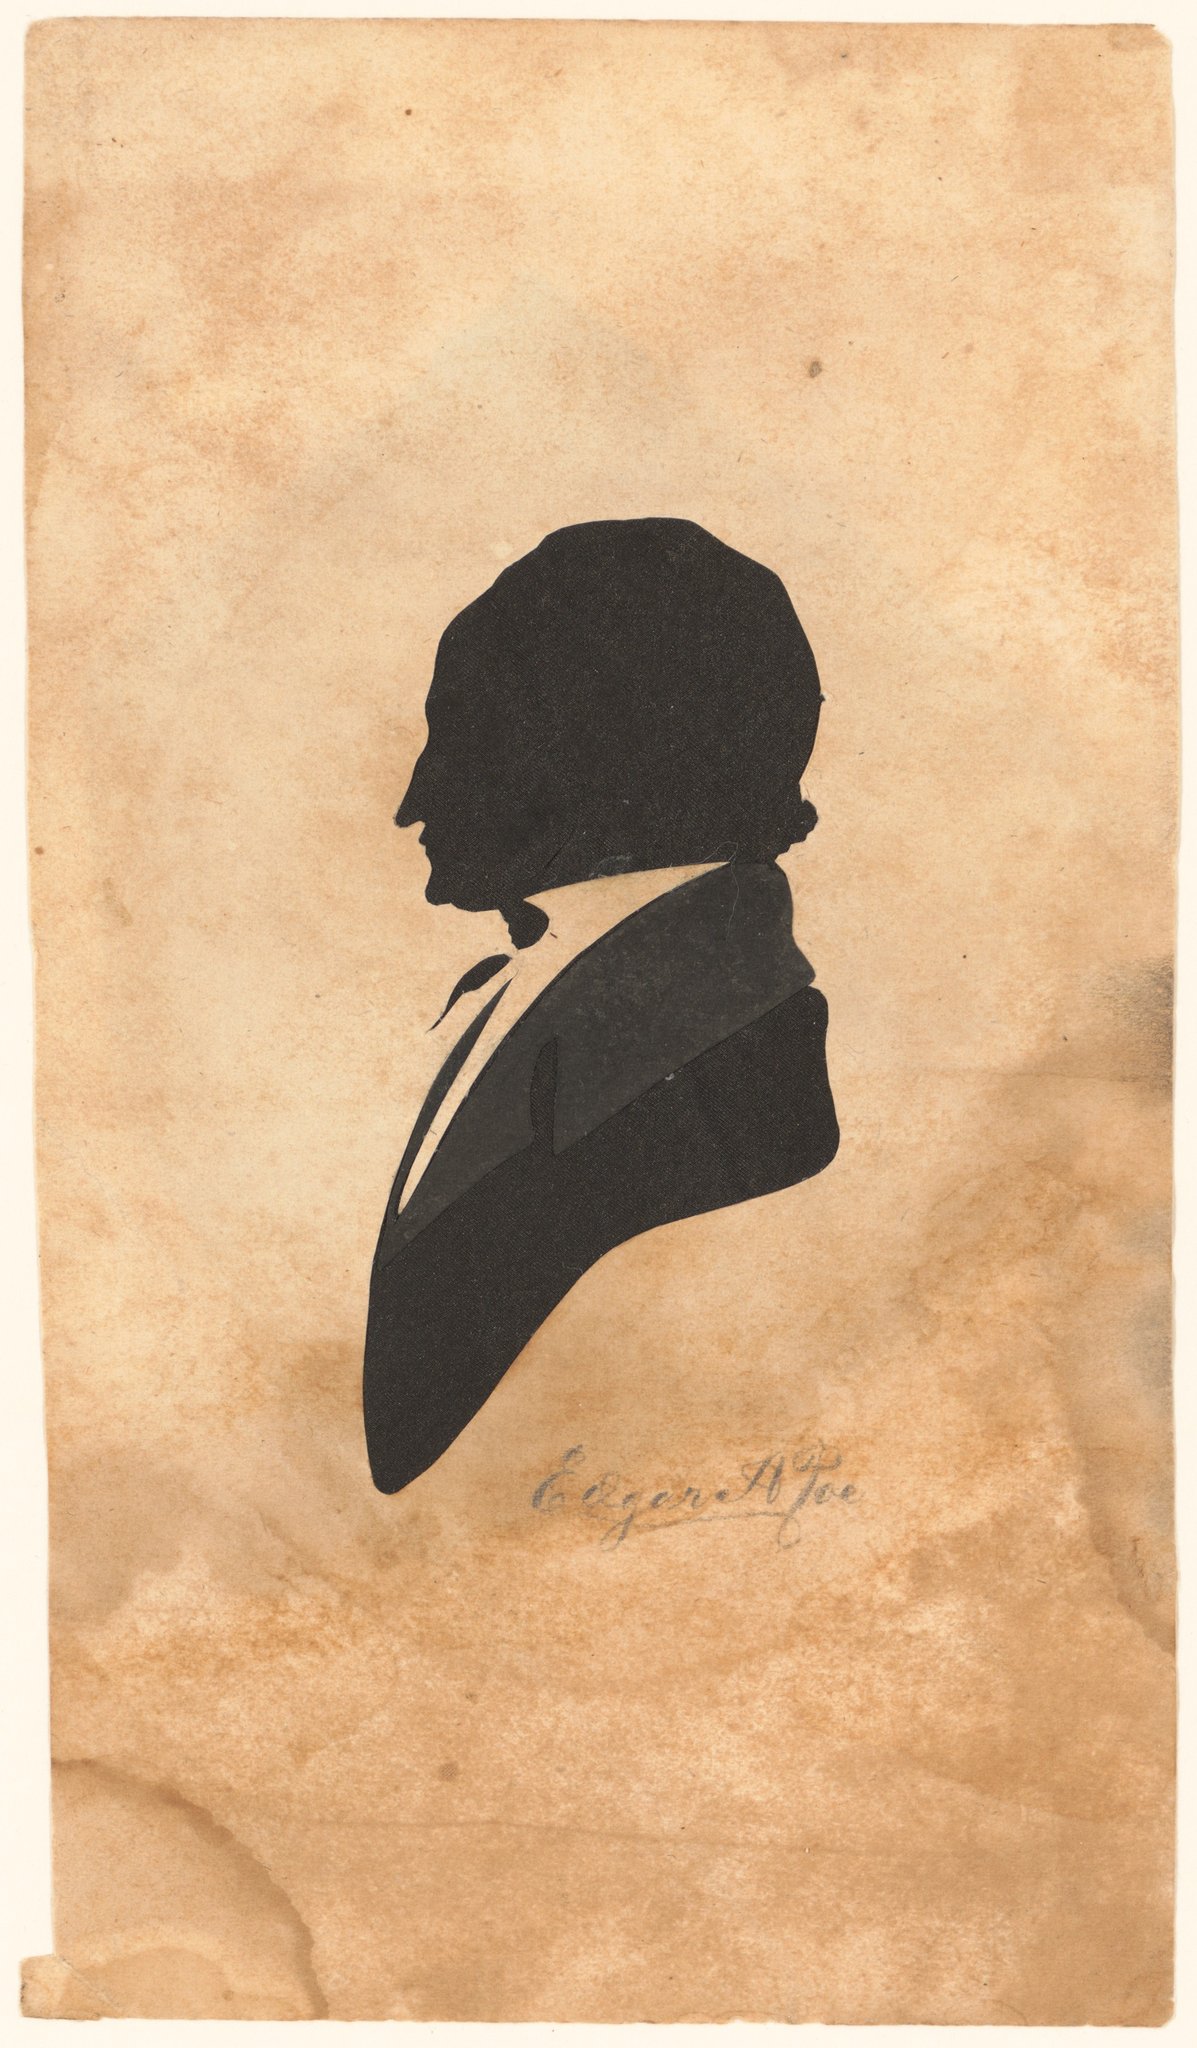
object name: cut paper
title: Edgar Allan Poe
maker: anonymous, american, 19th century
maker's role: artist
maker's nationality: american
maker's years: 1800-1900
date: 1801-1900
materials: paper, silk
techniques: cutting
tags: men,profiles